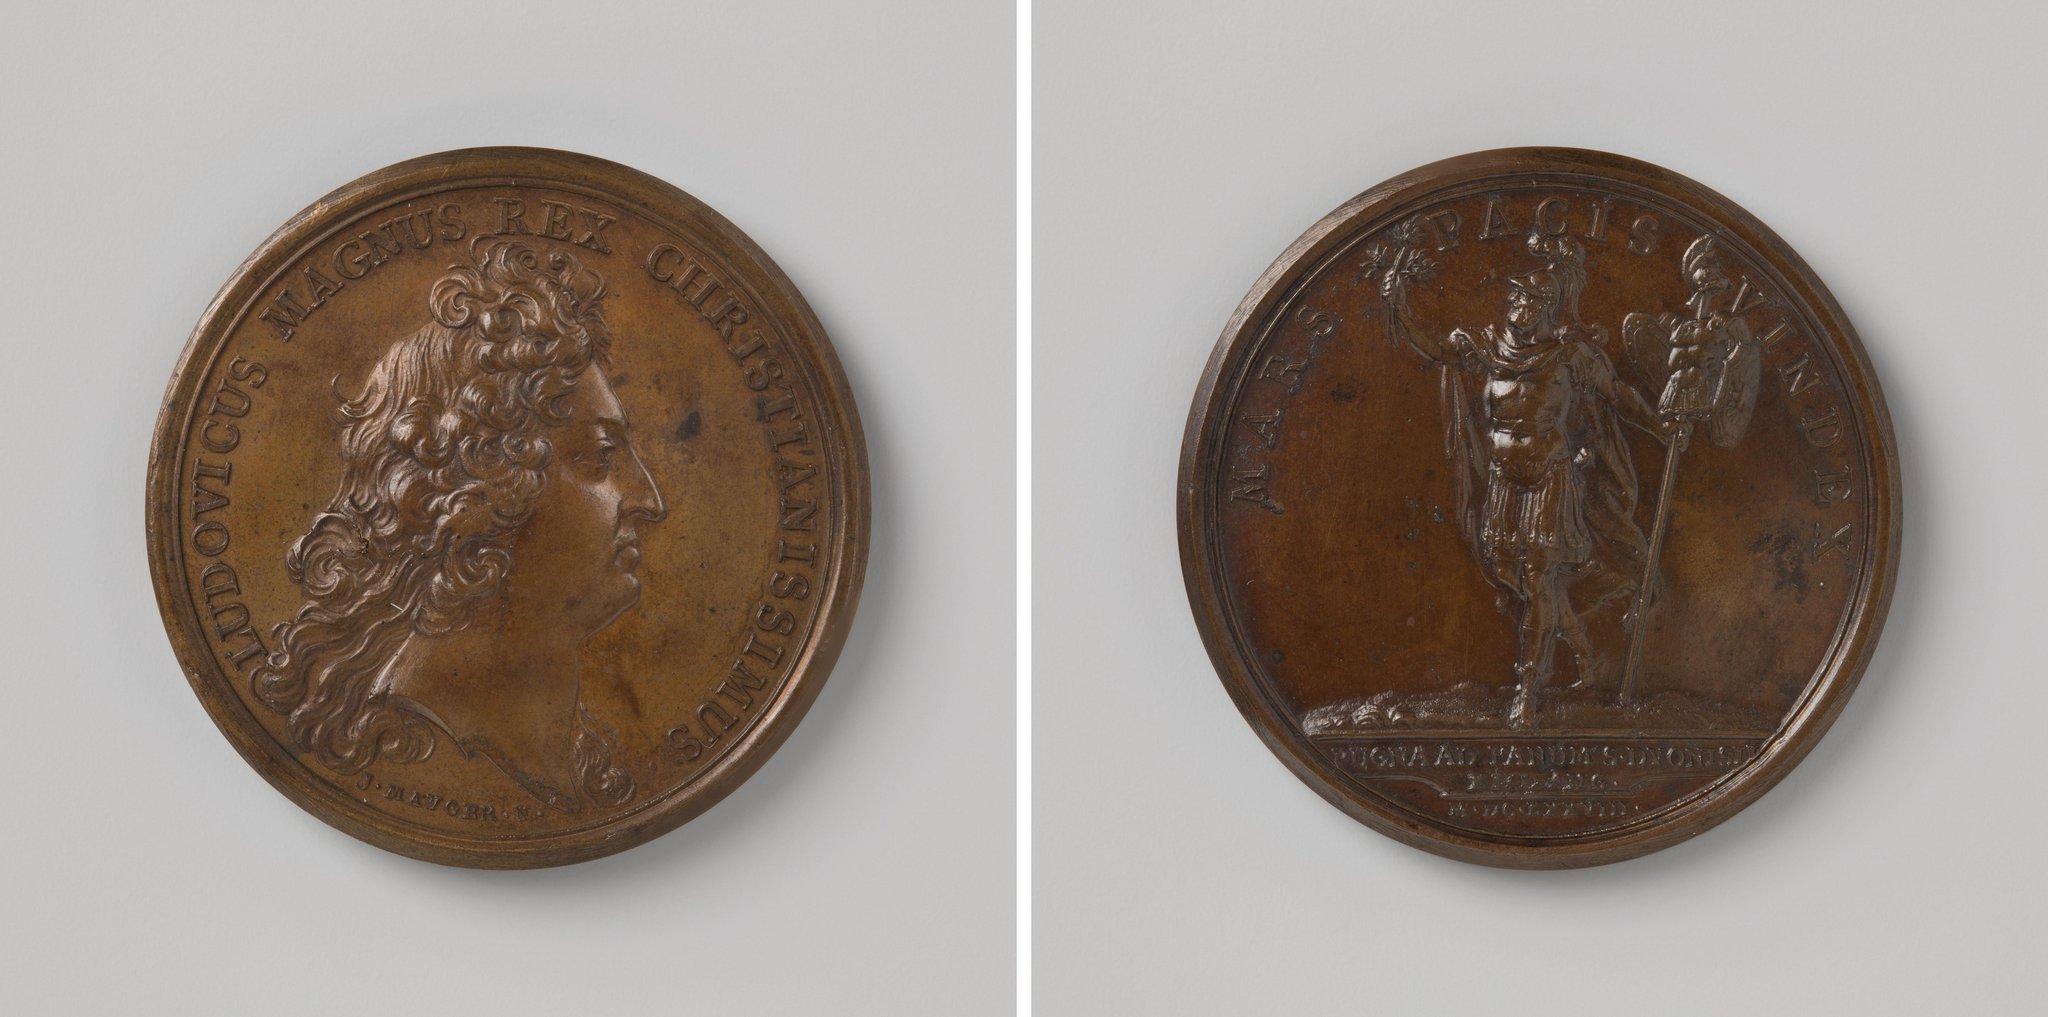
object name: history medal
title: Veldslag bij Saint-Denis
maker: jean mauger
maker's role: medailleur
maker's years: 1648-1722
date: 1699-1703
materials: bronze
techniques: striking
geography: paris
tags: lodewijk xiv (koning van frankrijk), henegouwen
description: Bronzen penning. Voorzijde: borststuk man binnen omschrift. Keerzijde: Mars met wapenstandaard en olijftak binnen omschrift; afsnede: opschrift